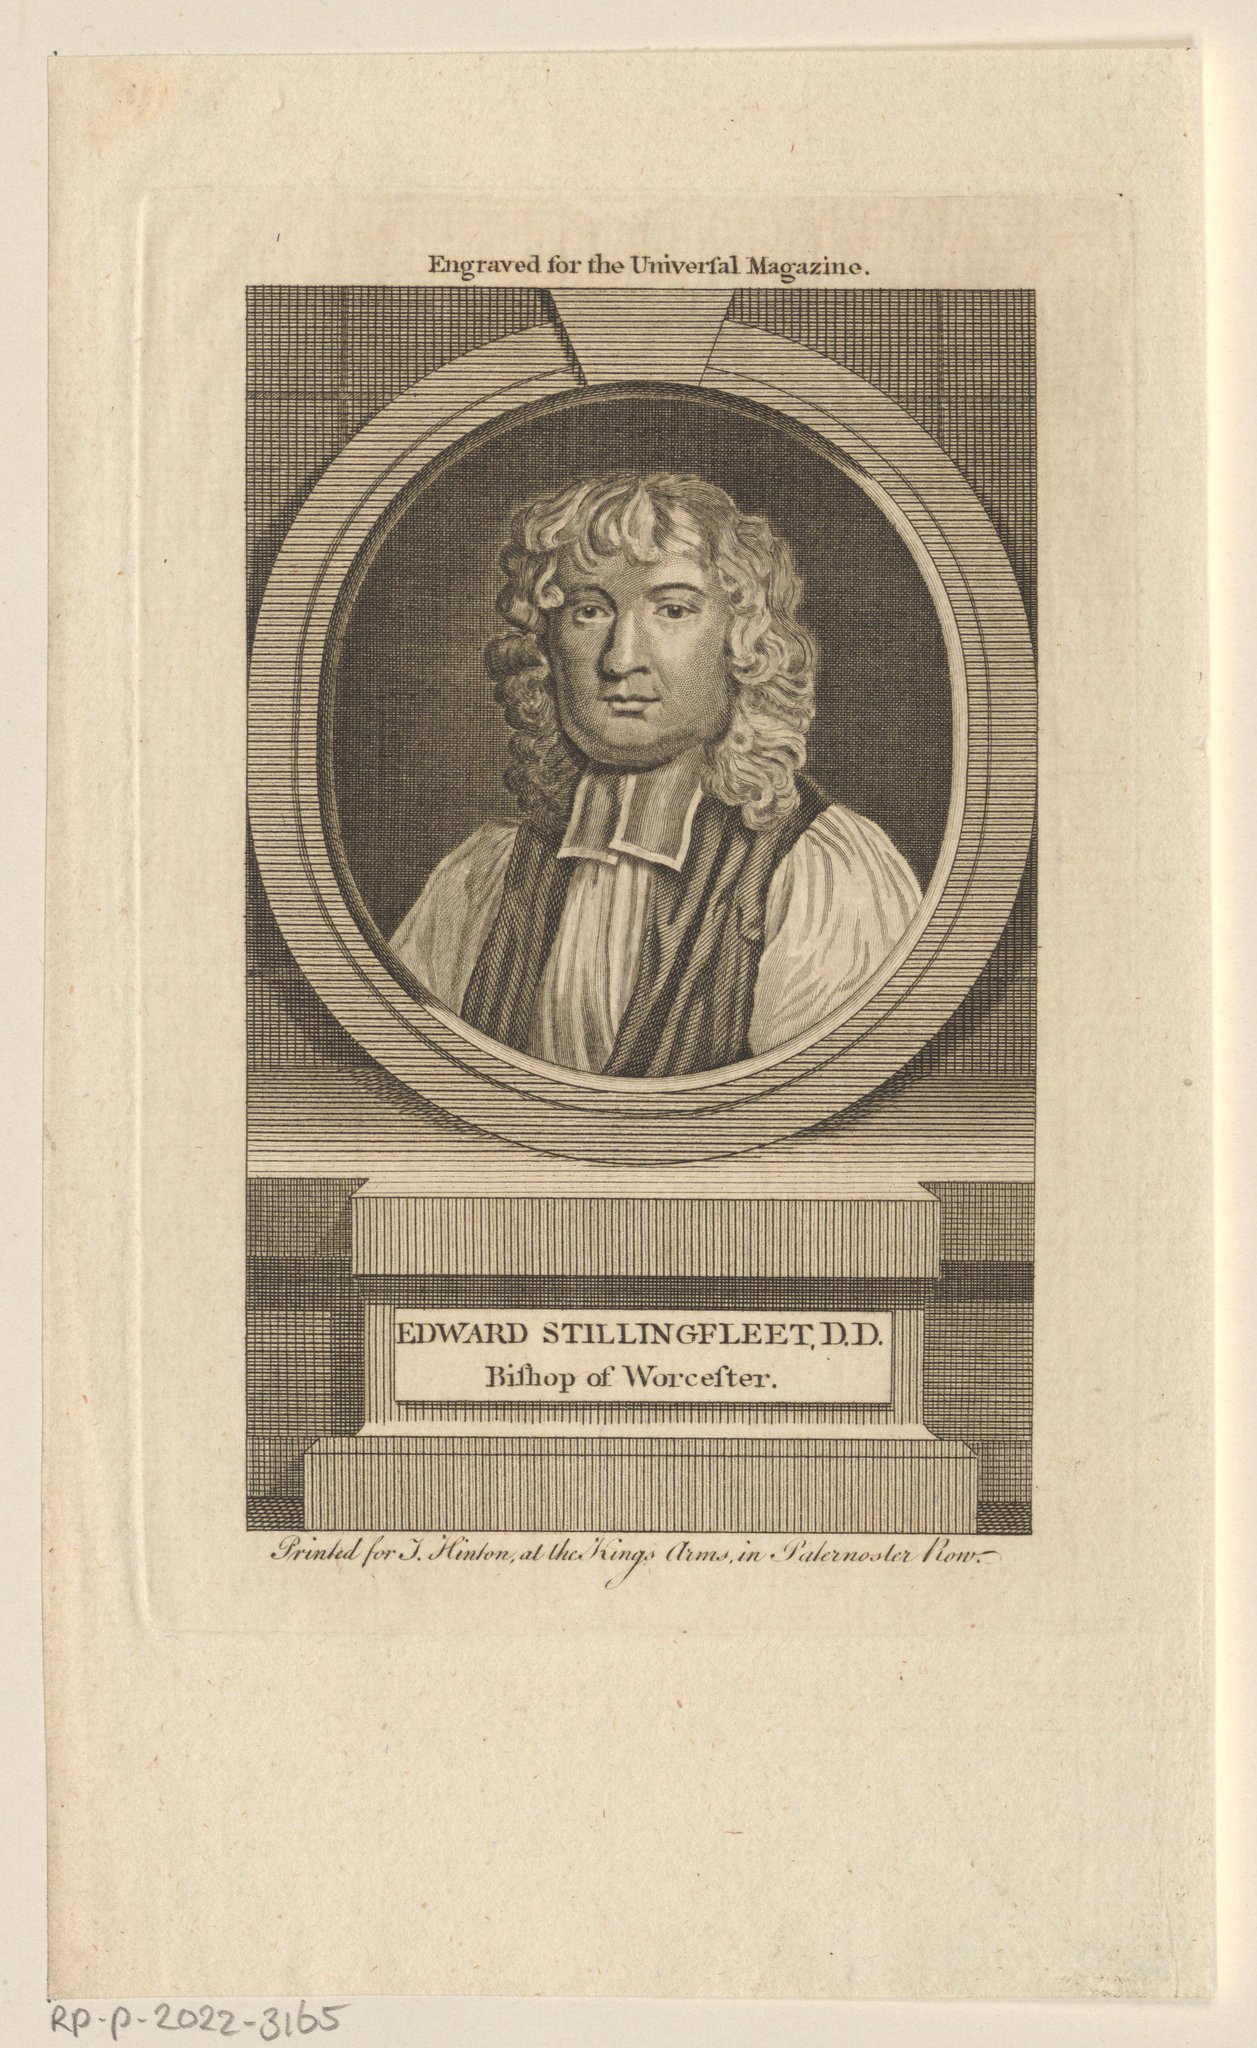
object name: print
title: Portret van Edward Stillingfleet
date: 1779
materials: paper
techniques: engraving, etching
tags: theologian, historical persons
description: Prent mogelijk uit: The Universal Magazine of Knowledge and Pleasure 64 (1779), mei 1779.